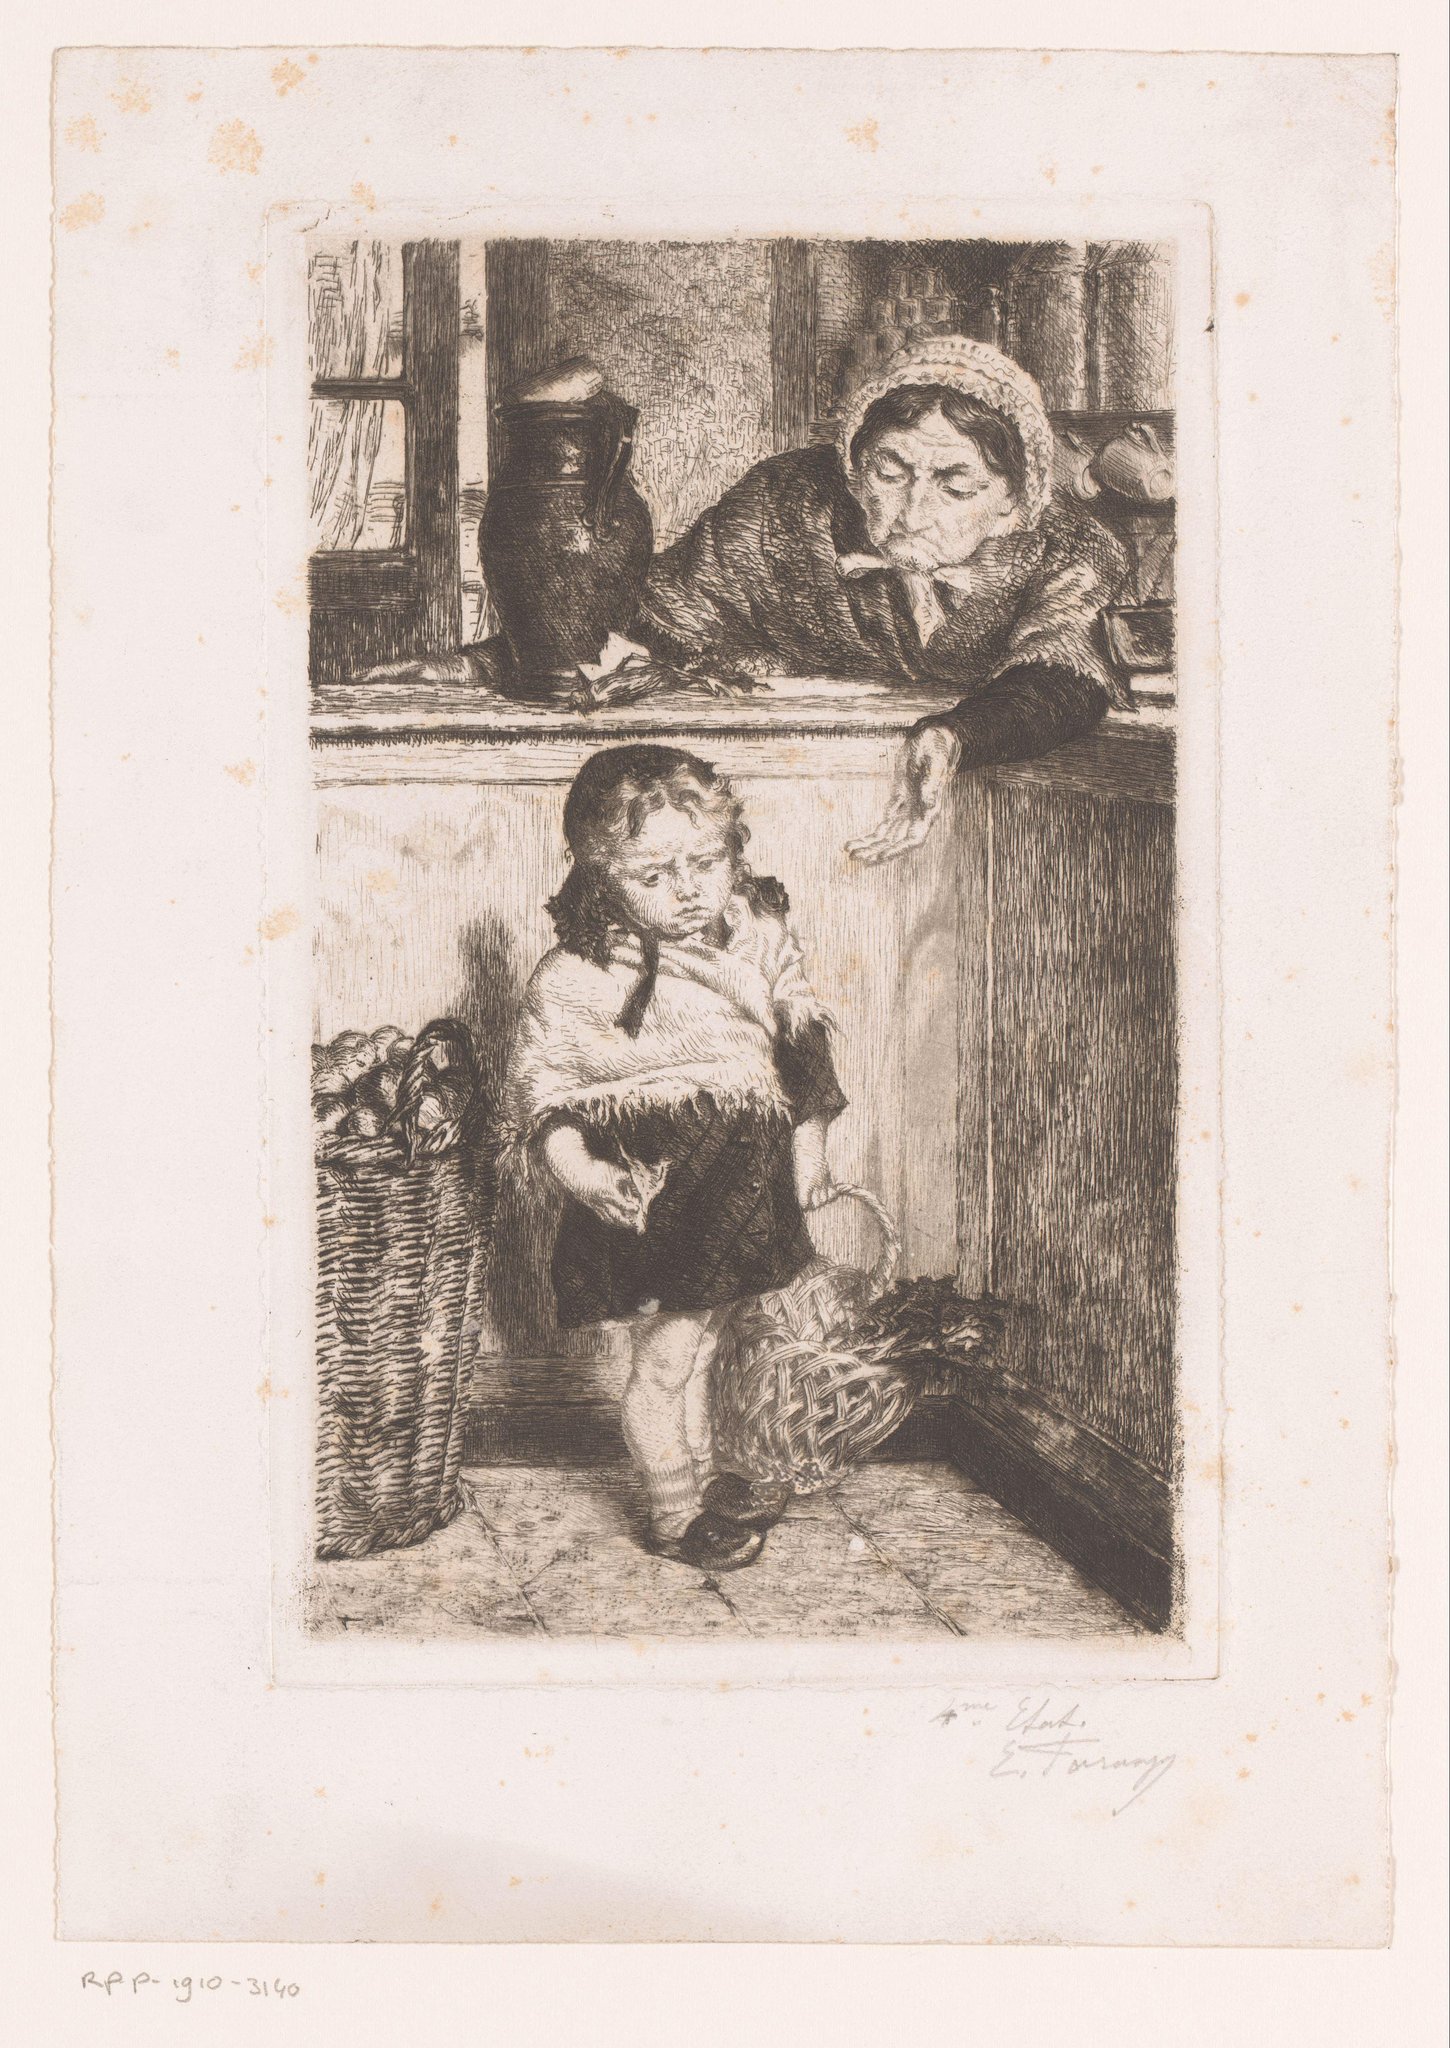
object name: print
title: Kind met mand bij een toonbank waarachter een vrouw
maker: edgard farasyn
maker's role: print maker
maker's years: 1858-1938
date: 1868-1910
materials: paper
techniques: etching, intaglio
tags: counter ~ shop, child, container made of plant material other than wood: basket, old woman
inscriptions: collector's mark: Lugt 2228, inscription: ‘4me Etat’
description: Het kind is bedroefd en voelt in de zakken omdat het onderweg het geld is verloren. De vrouw achter de toonbank steekt haar hand uit om af te rekenen.